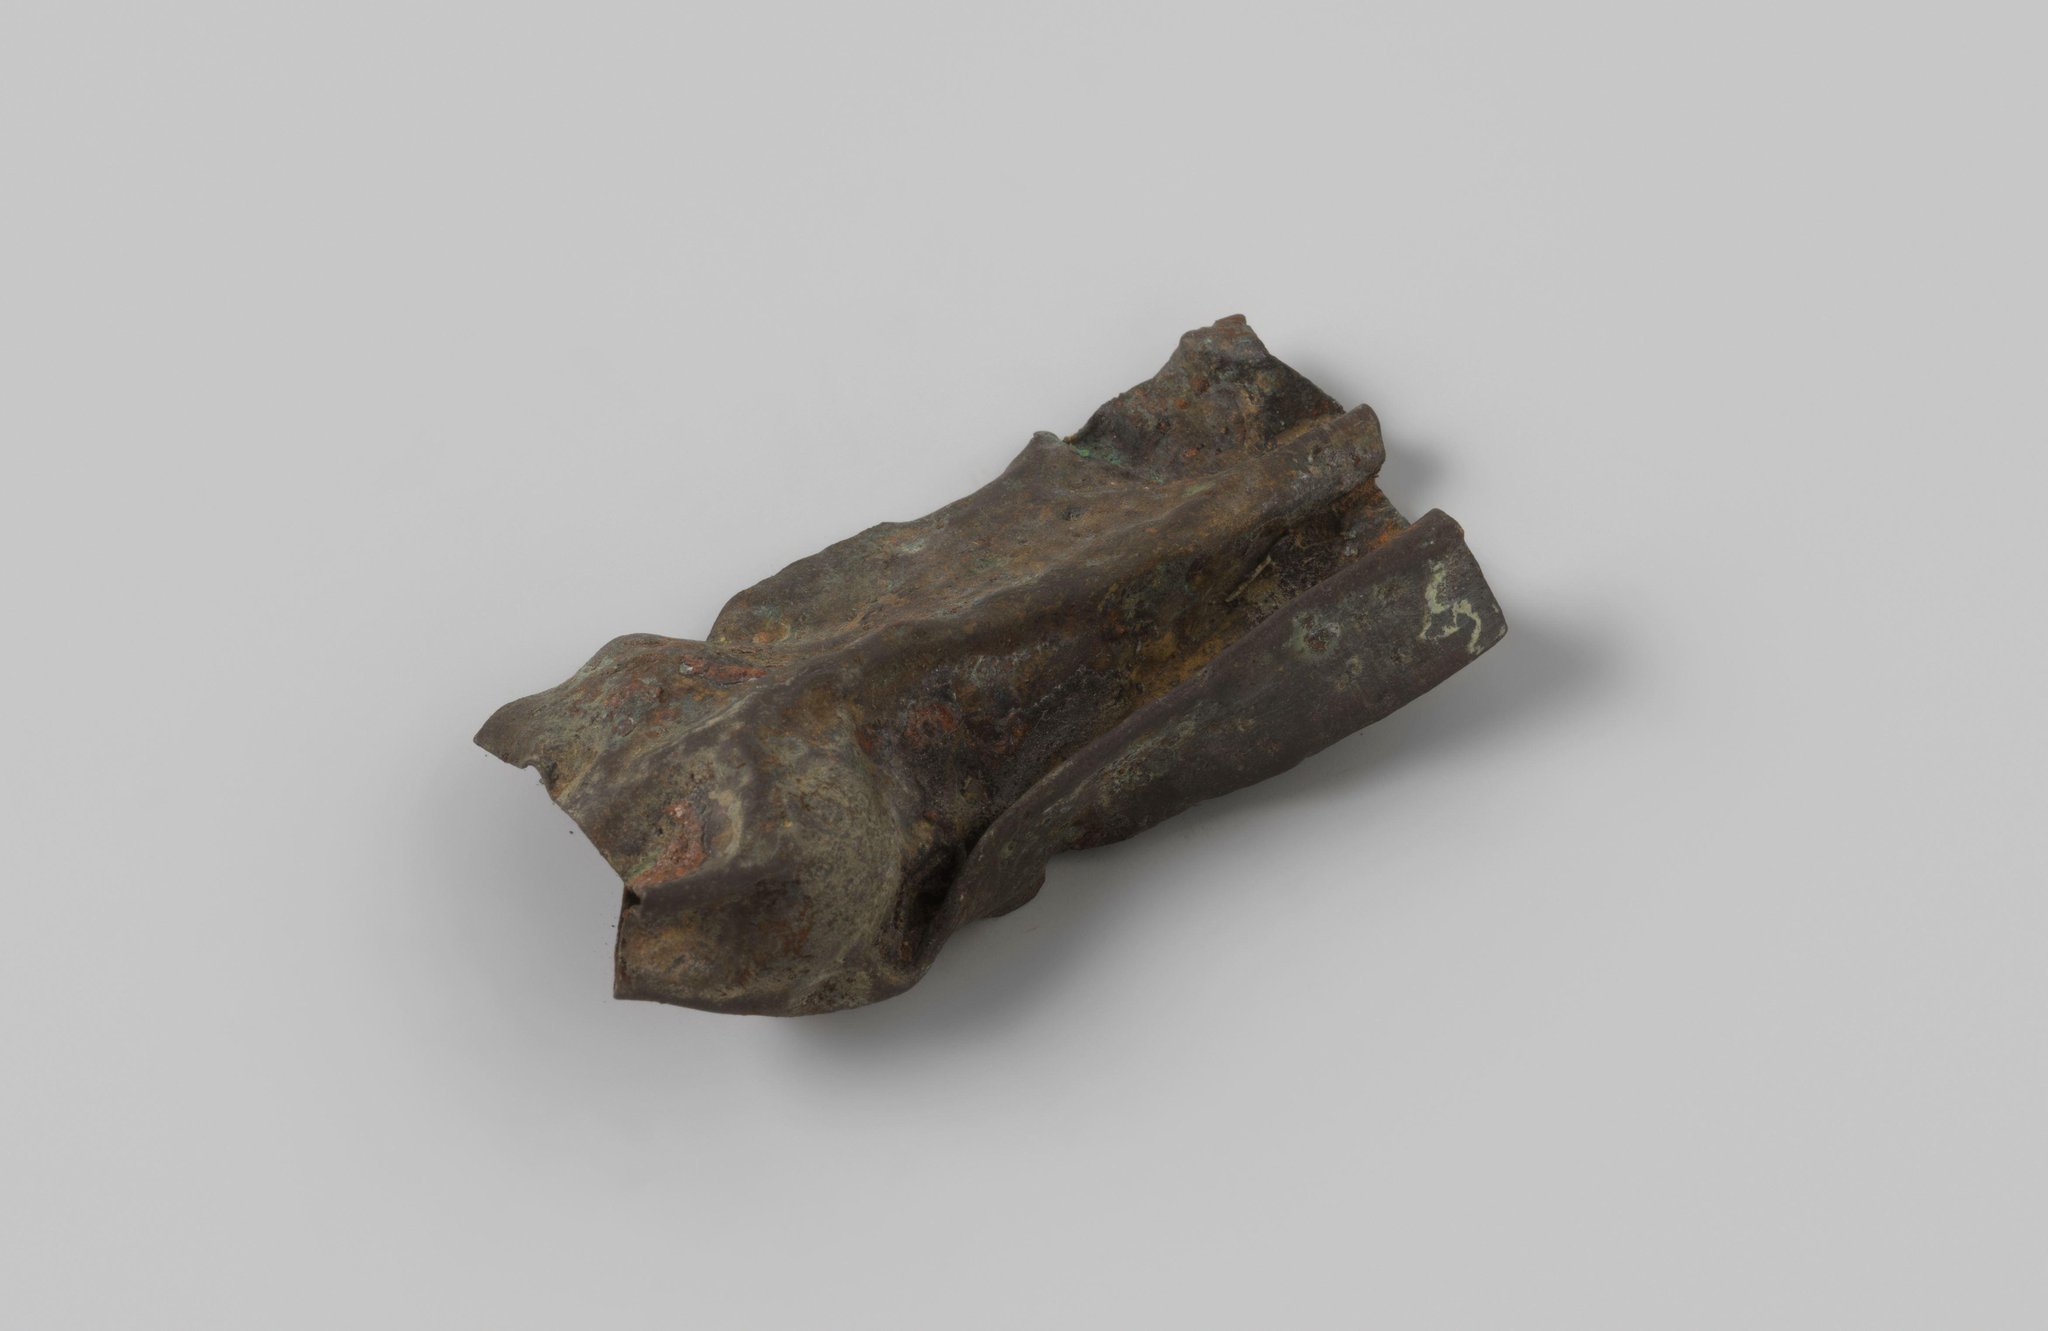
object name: cartridge shell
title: Patroonhuls uit het wrak van de Oost-Indiëvaarder Hollandia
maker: Anonymous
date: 1700-1743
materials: copper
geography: netherlands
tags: verenigde oostindische compagnie, hollandia (schip), annet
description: Cartridge case, tube; squashed, bent, id. NG 1979-205H549.